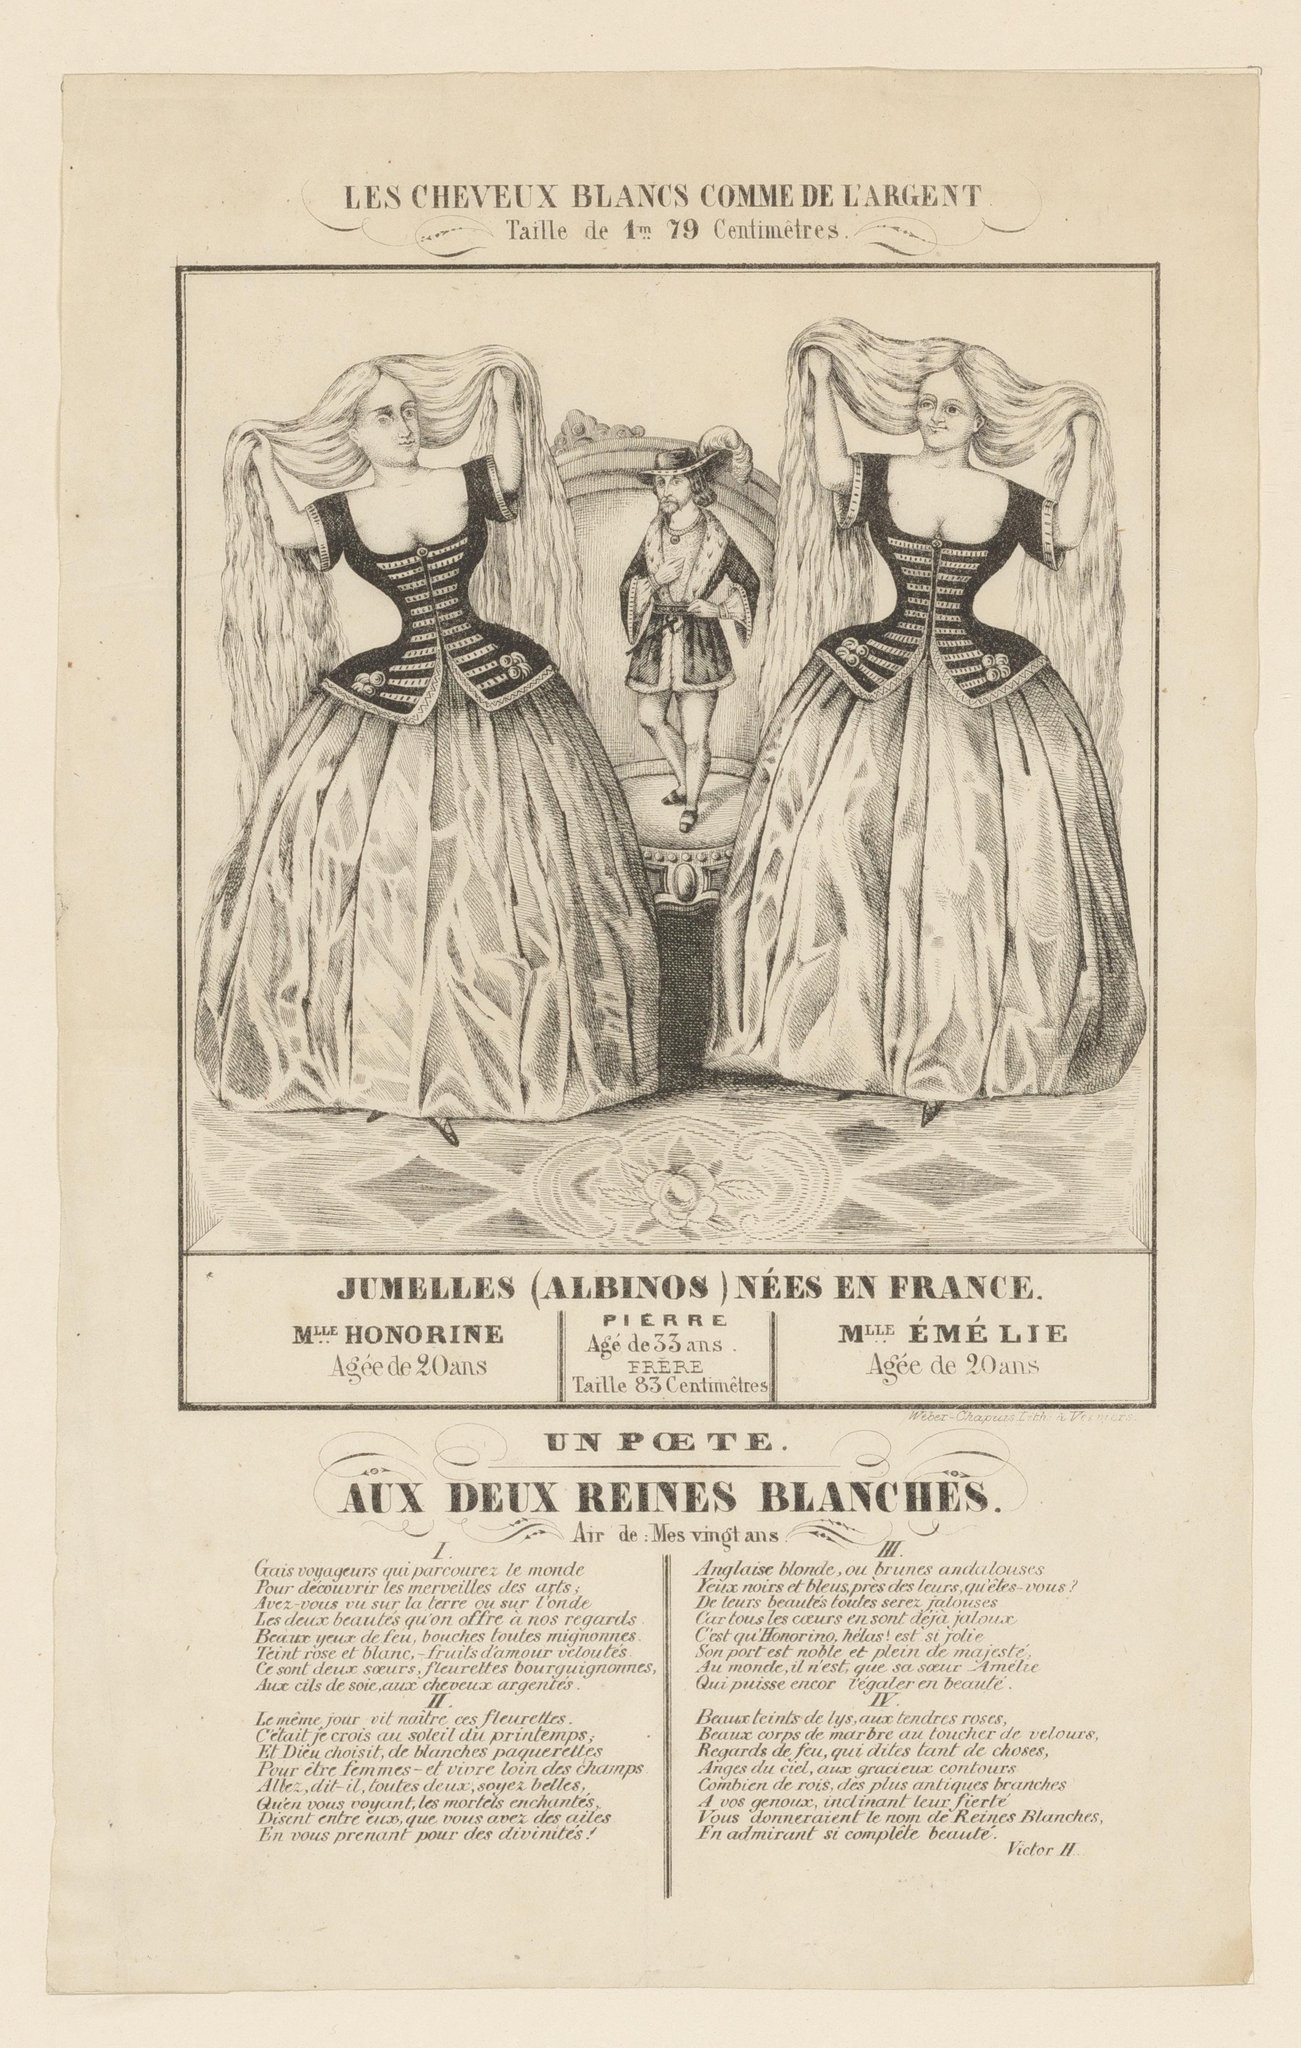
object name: print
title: Honorine en Émelie, twee zussen met zeer lang haar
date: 1850-1899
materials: paper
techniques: lithograph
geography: verviers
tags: hair, human beings (legendary or not) of abnormal proportions, size, strength, etc., human monstrosities ~ freak show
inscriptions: collector's mark, collector's mark: Lugt 1641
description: Honorine en Émelie, twee zussen met zeer lang haar. Tussen hun in staat een man van 83 centimeter. Onderaan een Franstalig vers. Onderwerpsrubrieken binnen de Atlas Zeden en Gewoonten: Zeden en Gewoonten in Engeren Zin. Volksleven. Volksfeesten. Kermistypen, wondermenschen en dergelijken.